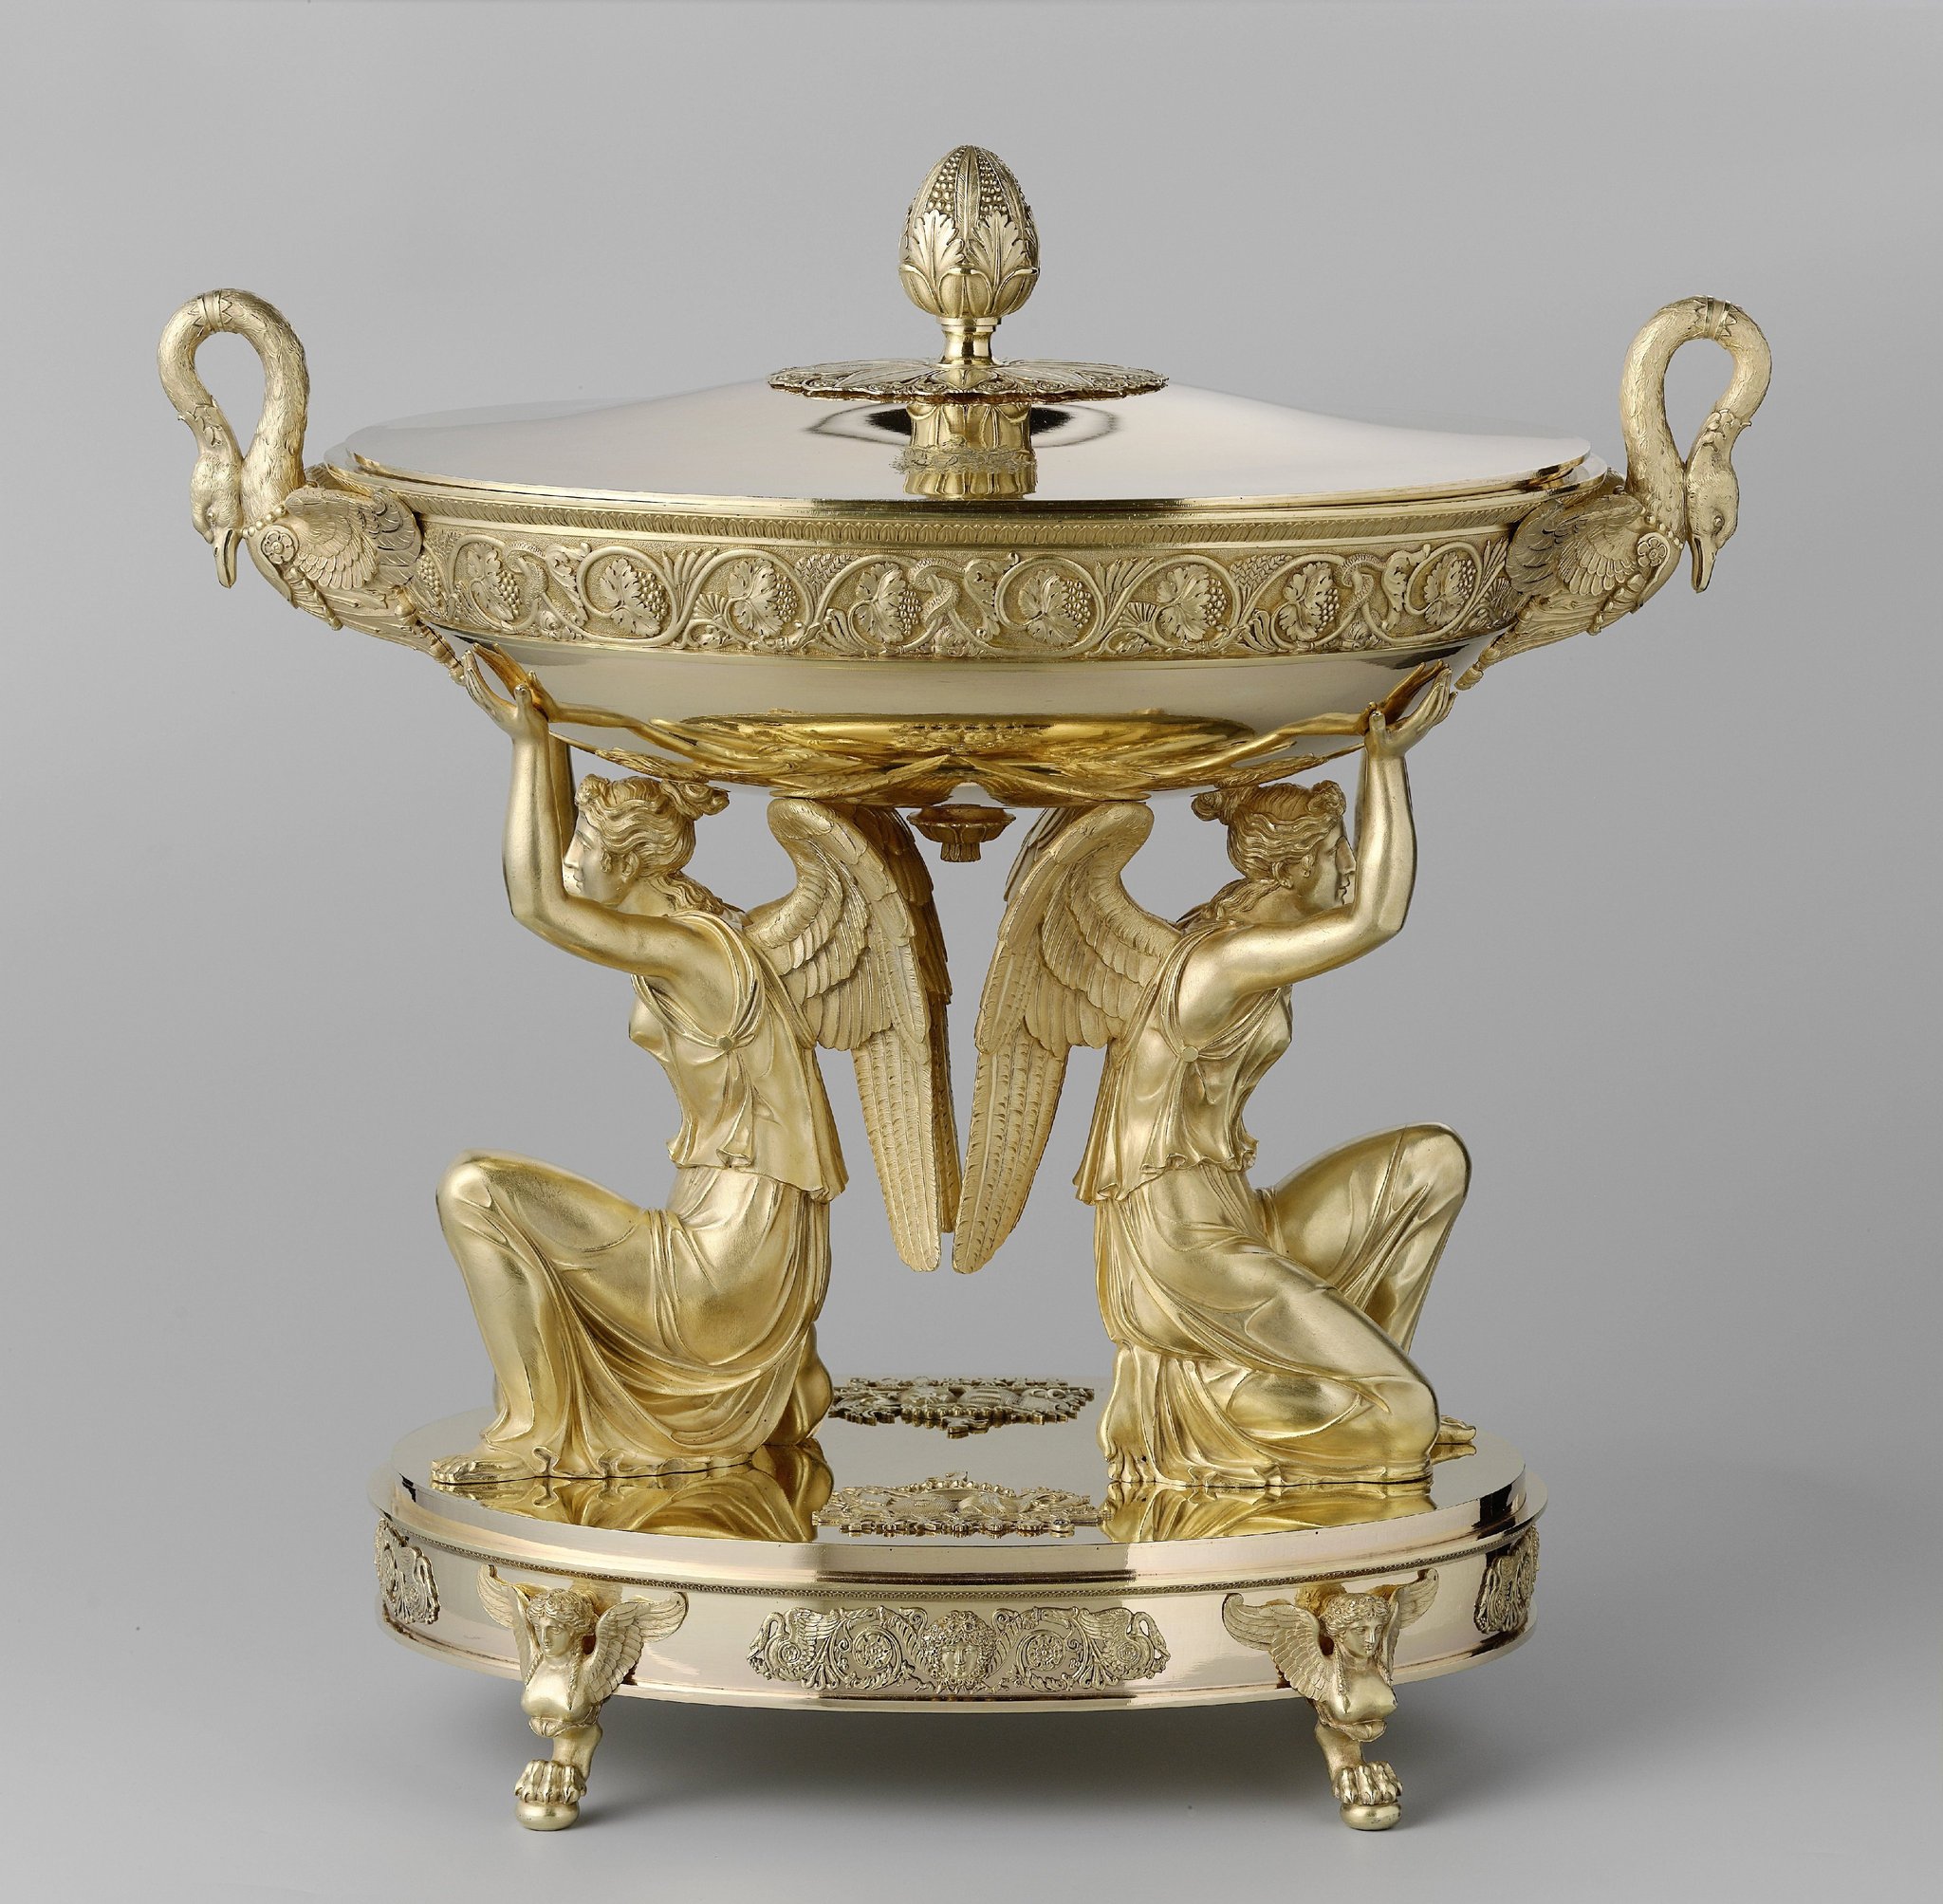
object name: tureen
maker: jean baptiste claude odiot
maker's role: jeweler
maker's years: 1763-1850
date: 1819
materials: silver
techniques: gilding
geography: paris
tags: ornaments ~ art, water-birds: swan, angels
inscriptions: countermark, alloy mark, retailer's mark, duty mark, maker's mark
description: These items are part of an 140-piece service that belonged to Alexandra Vasilievna Engelhardt, a noblewoman at the Russian court. The renowned silversmith Odiot collaborated with the painter Prud’hon and the architect Cavelier. They proudly presented their models at the French national crafts exhibition in 1819. The large late Empire figures, like the kneeling angels supporting the soup tureen, are striking.